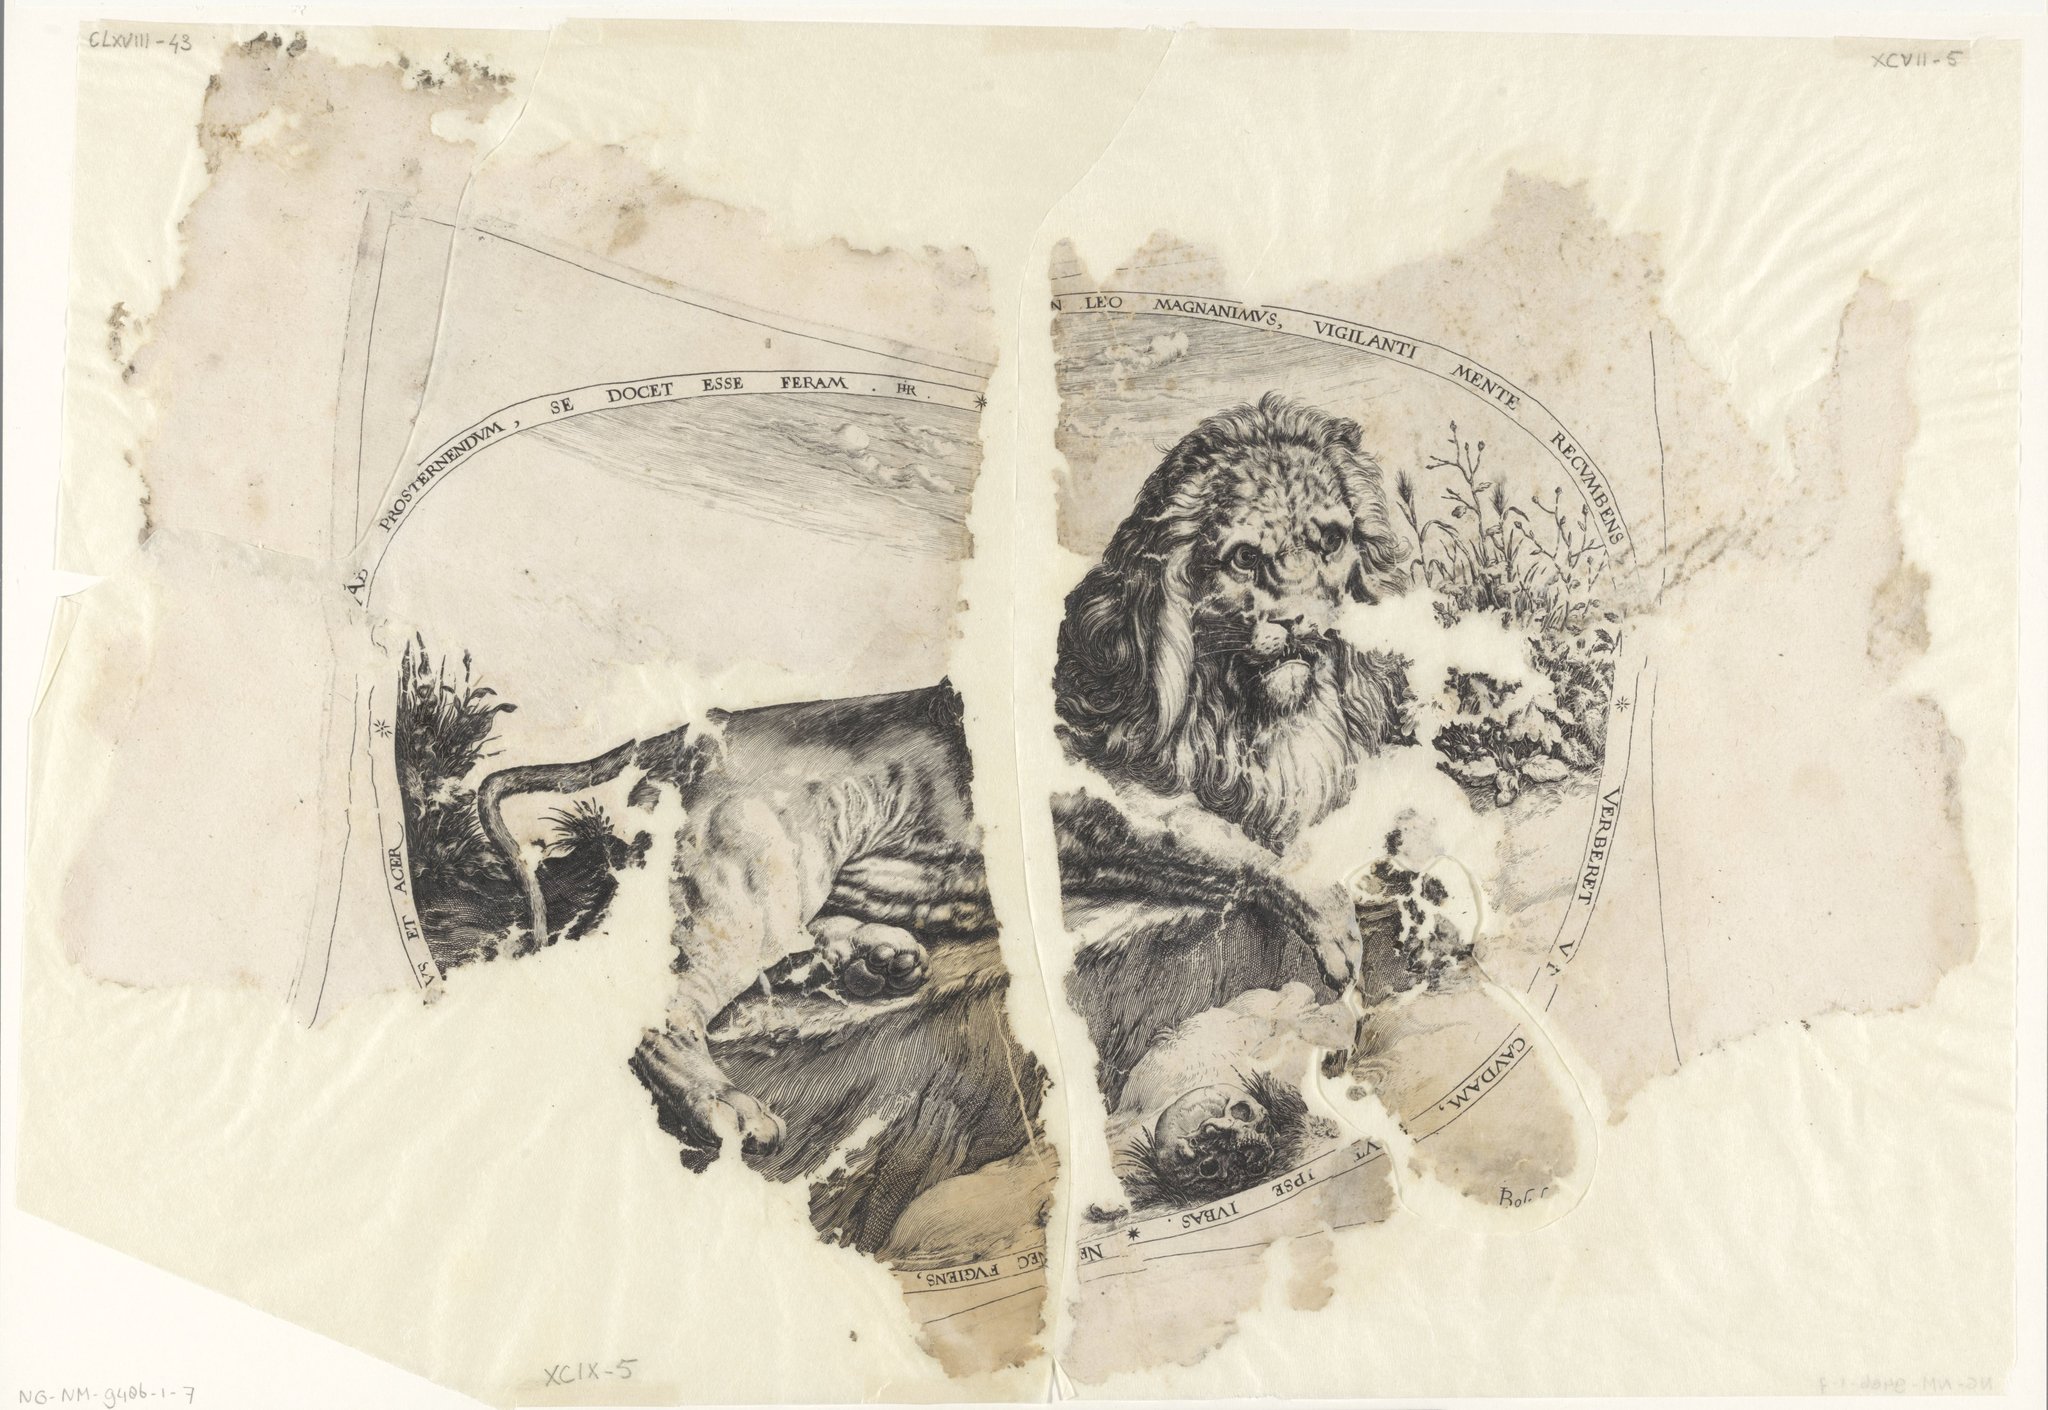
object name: print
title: Leeuw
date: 1580-1596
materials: paper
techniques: engraving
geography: northern netherlands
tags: beasts of prey, predatory animals: lion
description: De prenten in de Nova Zembla collectie zijn tijdens een expeditie van Willem Barendsz en Jacob van Heemskerk in 1596-1597 noodgedwongen in het winterkamp, het ‘Behouden Huis’, op het eiland achtergelaten. De prenten waren in één of meerdere stapels als handelswaar meegenomen vanuit Amsterdam. Bijna drie eeuwen later, in 1871, keerde de Noor Elling Carlsen terug naar Nova Zembla en vond daar de restanten van het ‘Behouden Huis, inclusief een groot deel van de inventaris. Een deel van de prenten, in de vorm van aaneengekoekte kluiten, werd toen ook teruggevonden. De papierkluiten waren soms op meerdere plekken gebroken. Tussen 1975-1979 zijn de prenten van elkaar gescheiden. Dit leverde in totaal ca. 1000 fragmenten van ca. 400 afdrukken van ca. 150 verschillende prenten op. Voor zover mogelijk zijn de fragmenten samengevoegd en zijn de prenten gereconstrueerd.